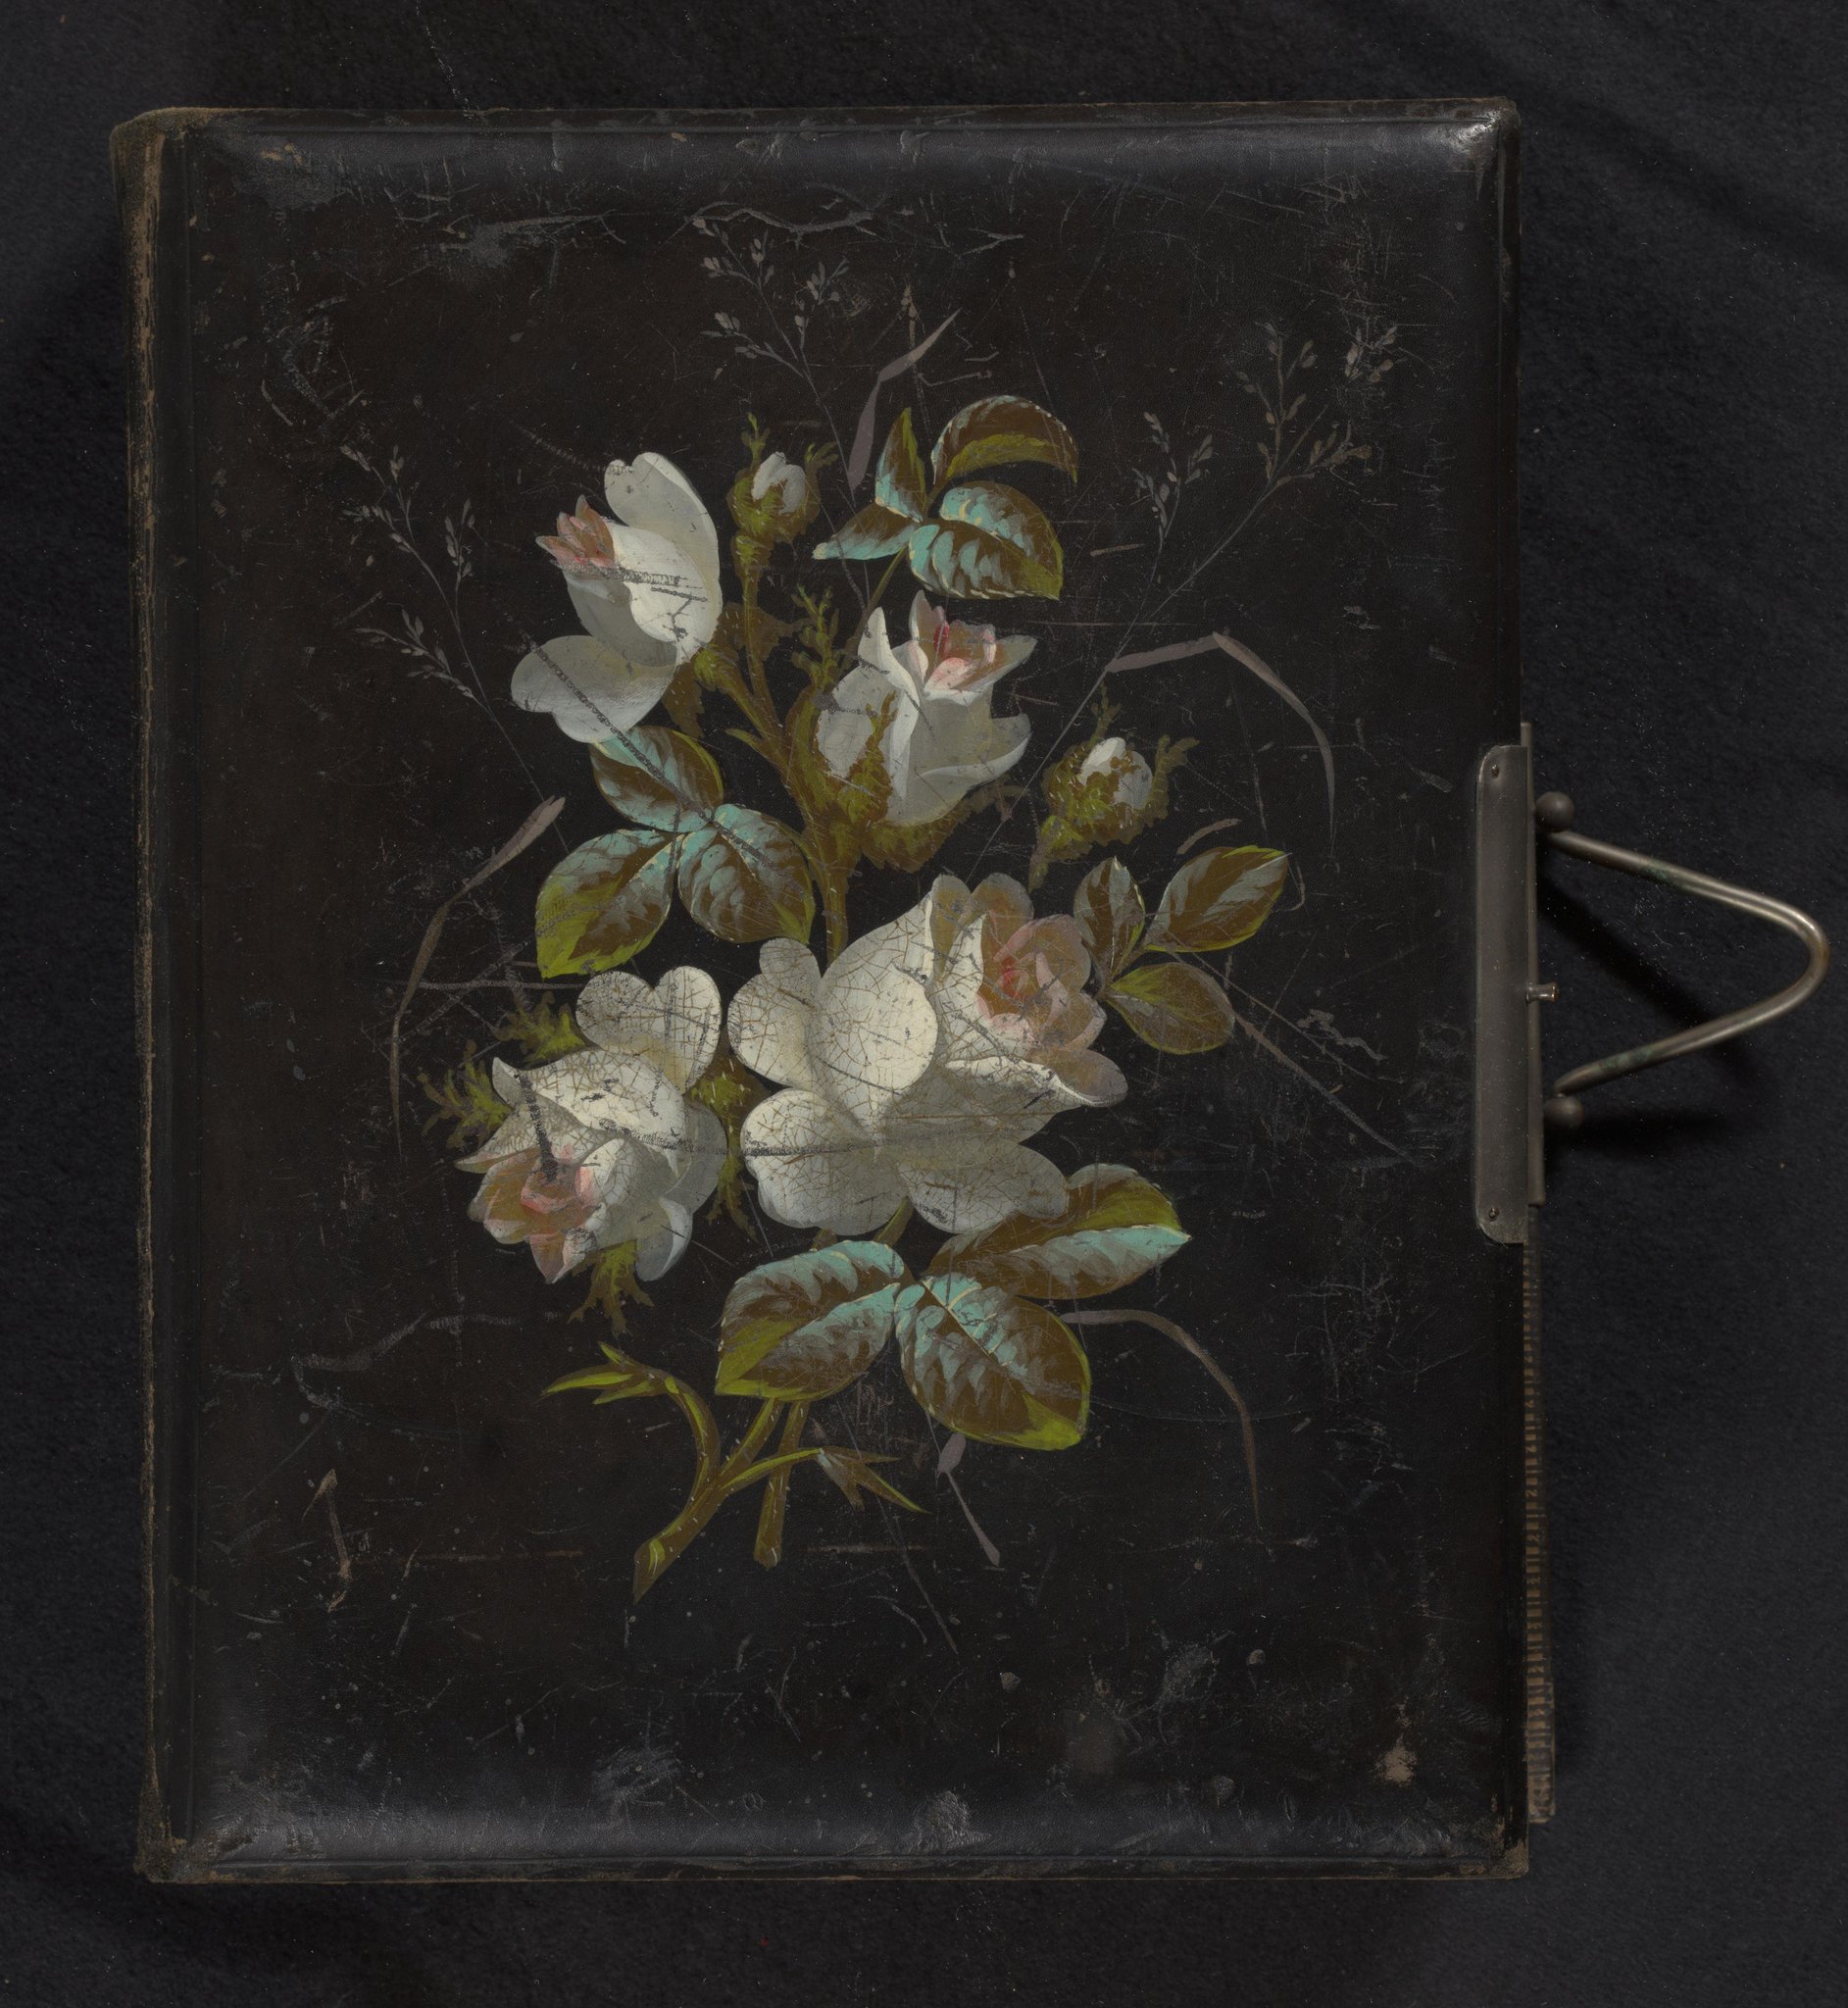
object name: slip in album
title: Fotoalbum met 64 foto's, Nederlands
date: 1860-1920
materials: cardboard, chromium, leather, paper, photographic support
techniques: albumen print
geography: amsterdam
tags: historical persons - bb - woman, boy (child between toddler and youth), moustache, child, historical persons, girl (child between toddler and youth), head-gear: hat, head-gear: cap, beard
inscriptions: number: ‘240/ 40’, number: ‘N 180’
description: Fotoalbum met 64 foto's op 21 bladen met insteekpasse-partouts. Het album bevat naast een foto van een kat alleen portretten. Enkele namen van de geportretteerden zijn bekend, onder andere Dirk de Roever, Eduard Donker en Jane Kuikhoven, het merendeel is onbekend. De foto's zijn van diverse vervaardigers, onder andere Albert Greiner, Cornelis Johannes Lodewicus Vermeulen en Max Büttinghausen, enkele foto's zijn anoniem. Het album is leeg gekocht en gevuld met foto's uit een album van Geraldine of Gertrude Donker door L.J. Hartkamp.